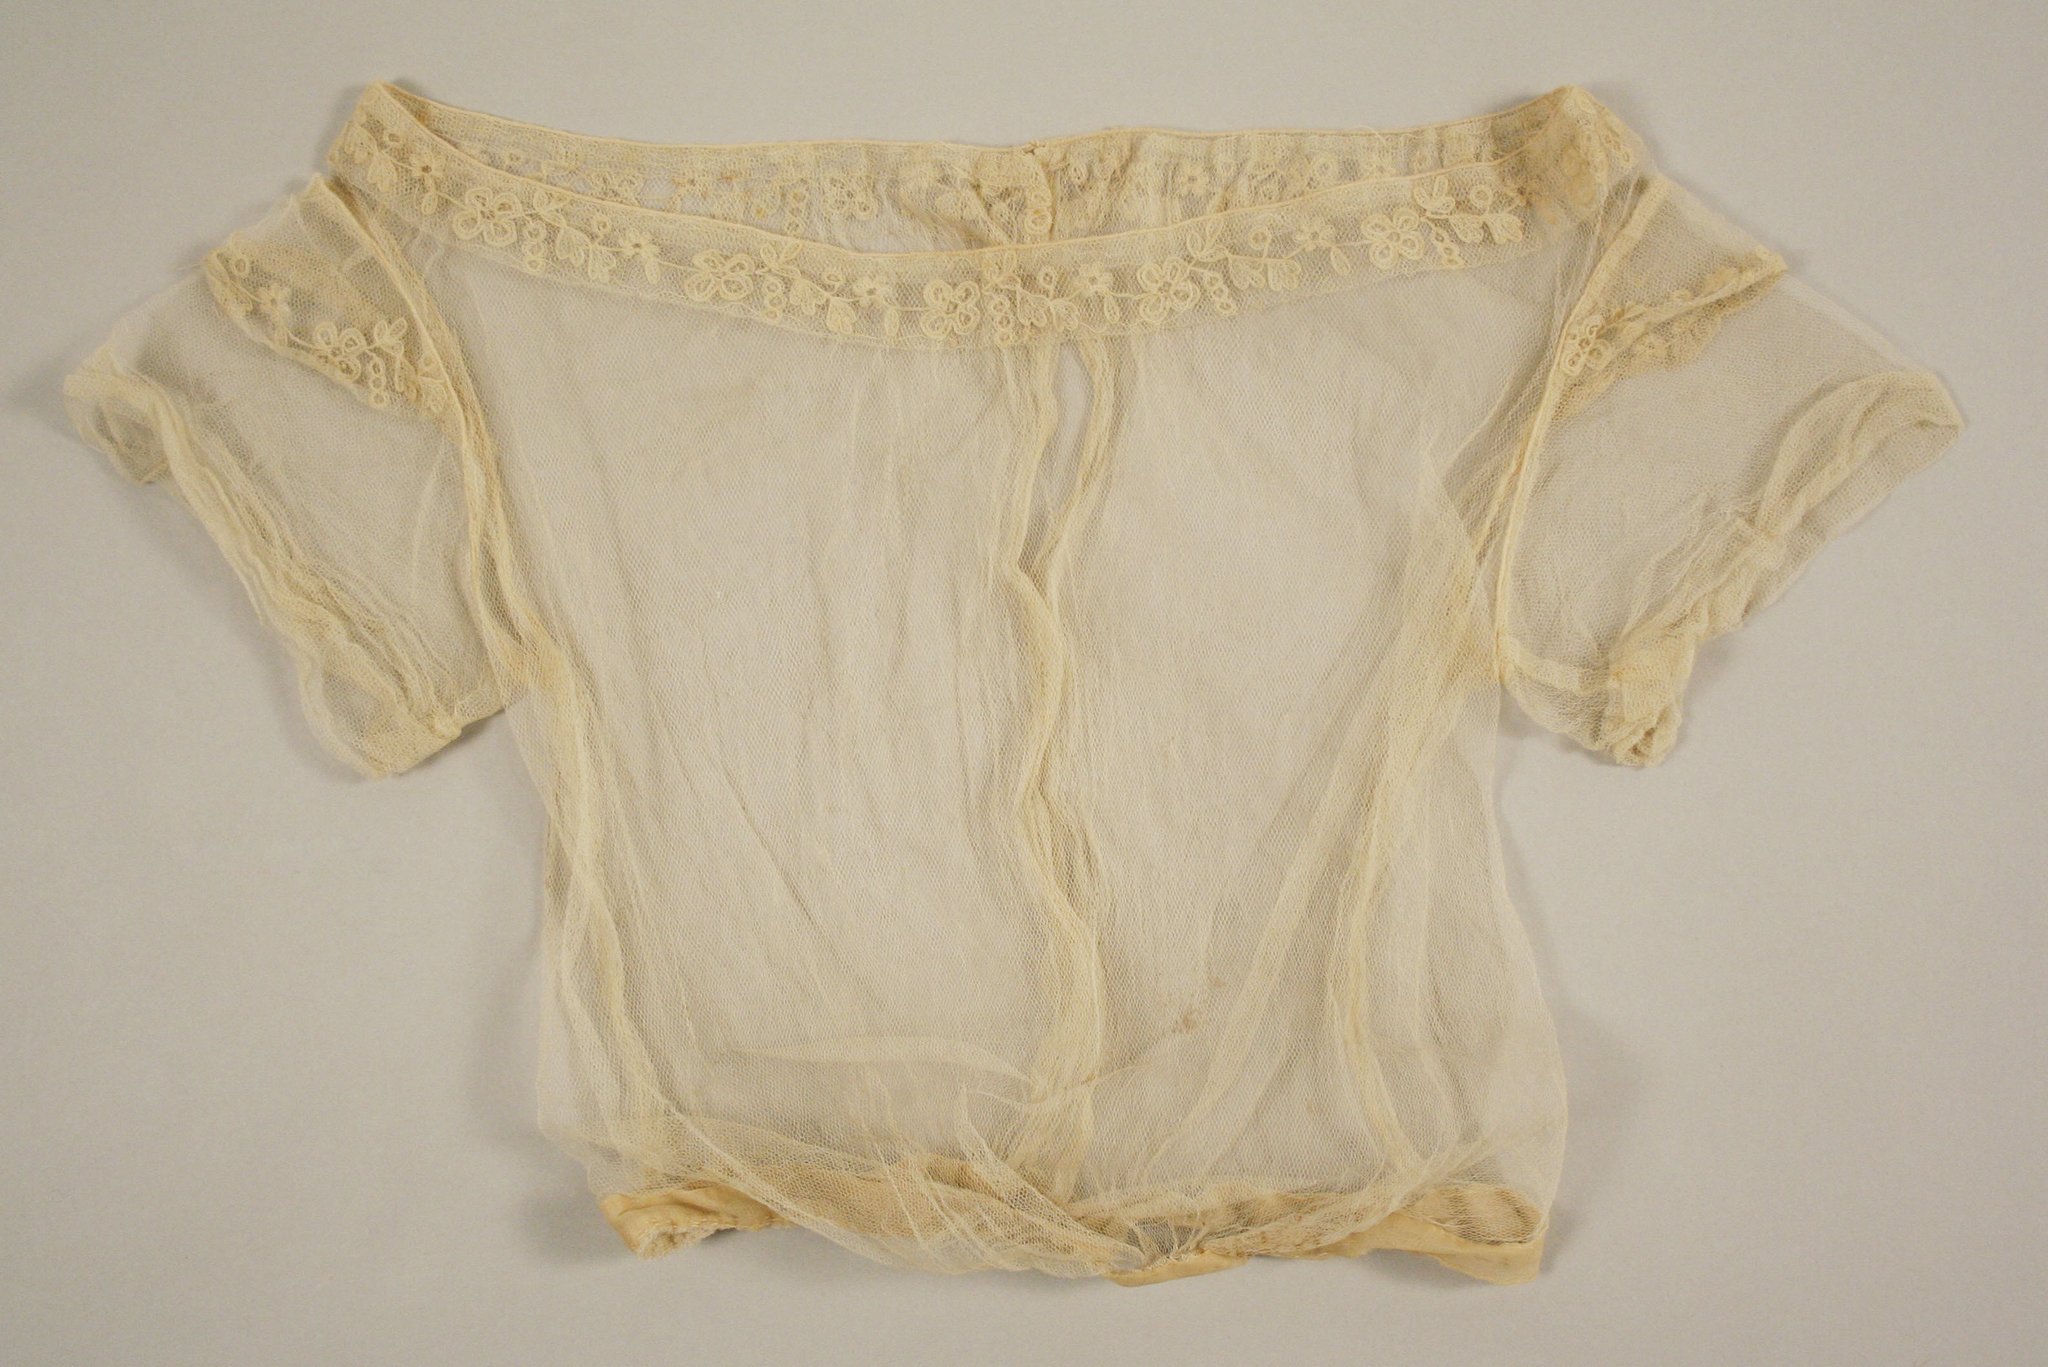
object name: bodice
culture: american or european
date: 1815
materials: cotton